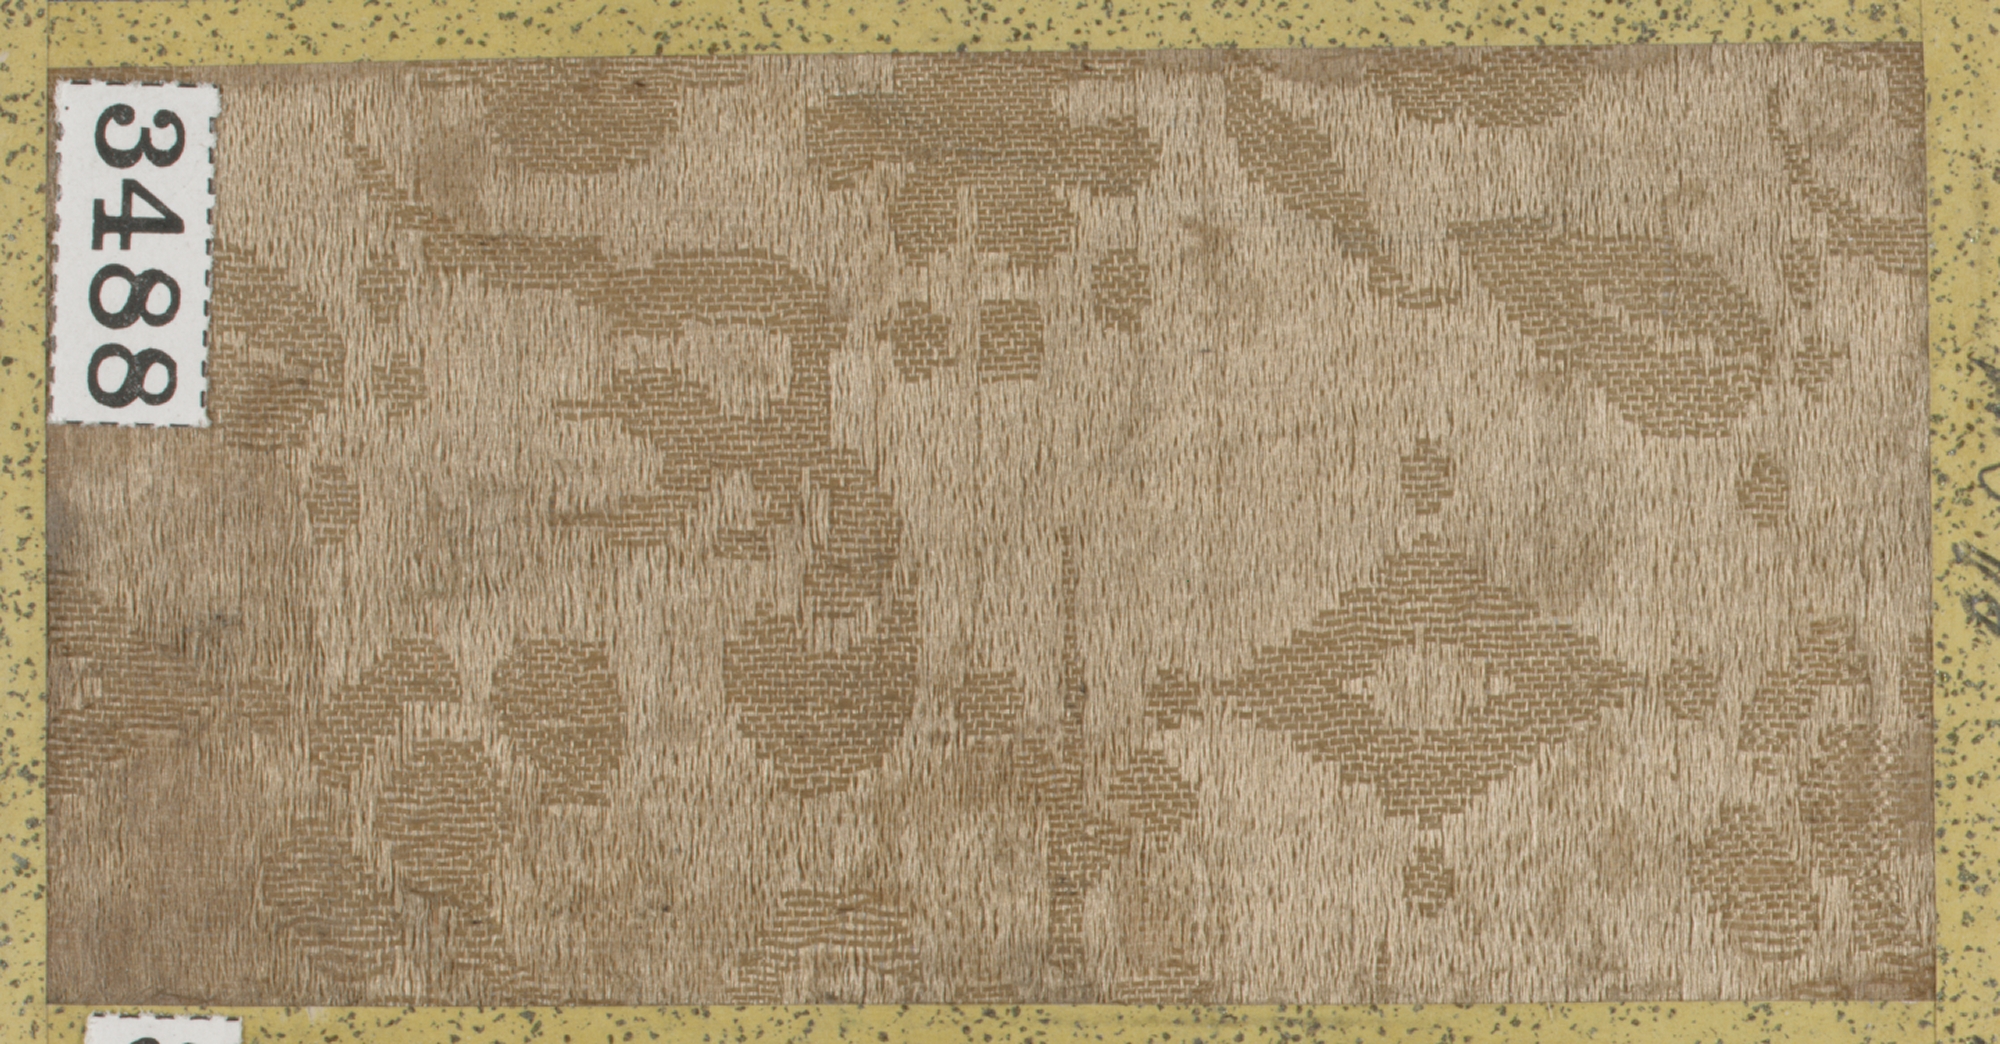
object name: sample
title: Textile Sample from Sample Book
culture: japanese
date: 1801-1900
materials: silk